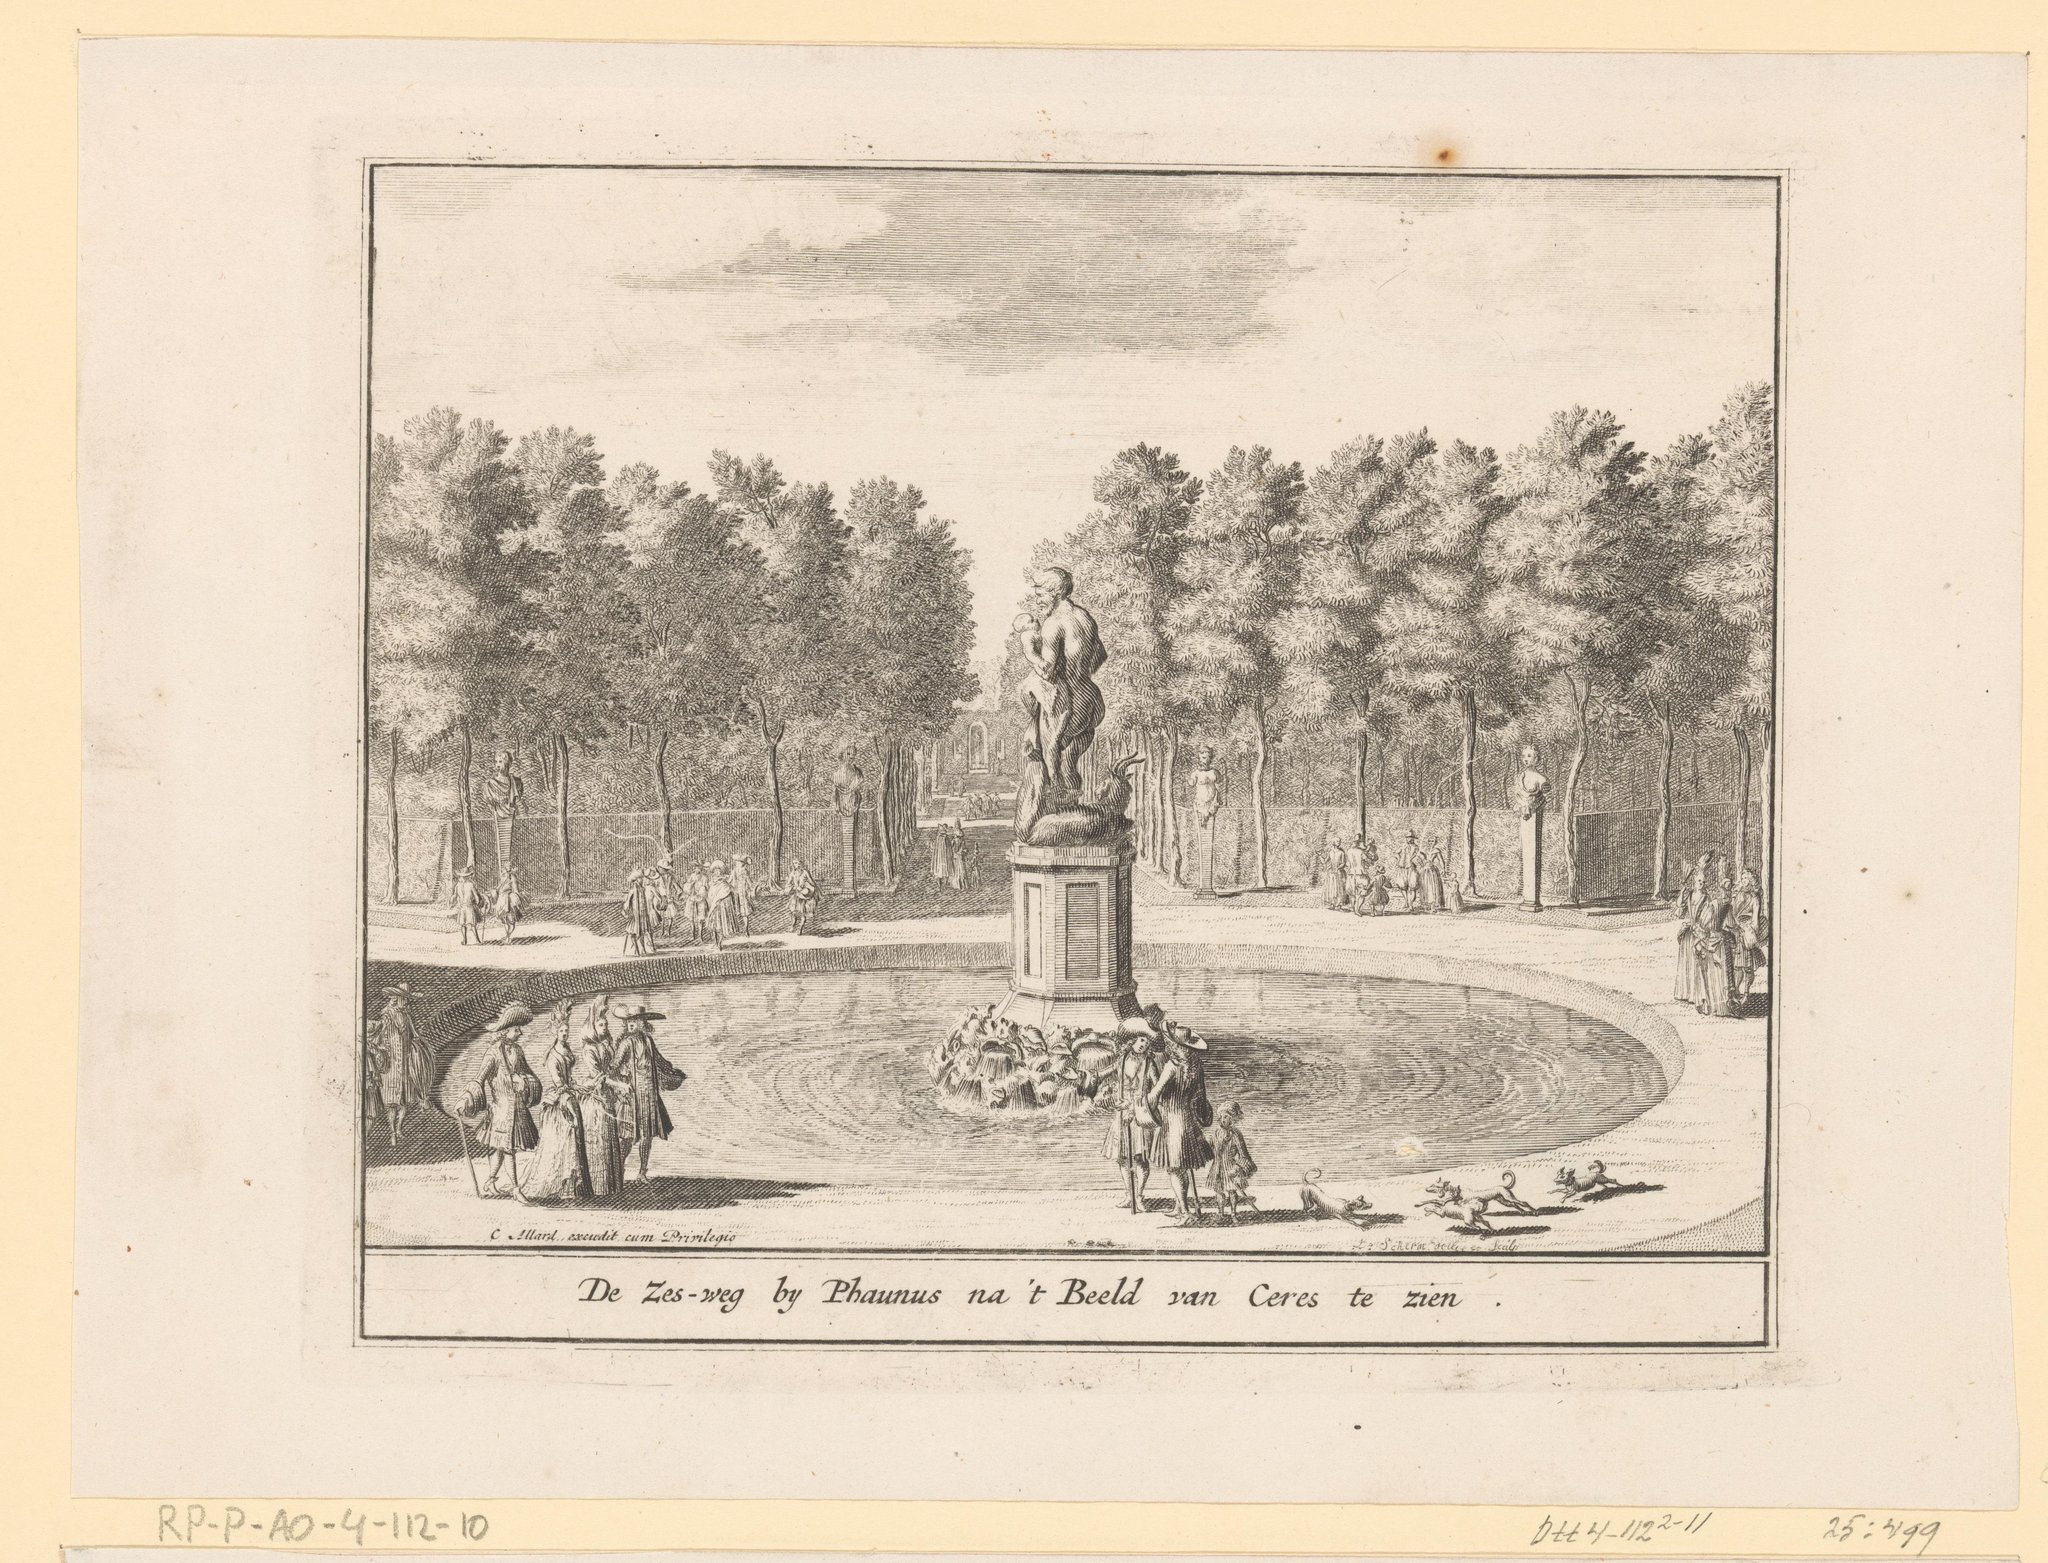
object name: print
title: De Laan na Ceres, tegen over 't Beeld van Phaunus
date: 1689-1702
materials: paper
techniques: engraving, etching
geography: amsterdam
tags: the hague, william iii (prince of orange and king of england, scotland, and ireland), (story of) ceres (demeter), palace, french or architectonic garden; formal garden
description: Prent ook gebruikt in: Allard, Carel. Neerlands veldpracht, of 't Lusthof gesticht door Z.B.M. Willem III op't Loo (...). Amsterdam: Carel Allard, s.a. [1702?].